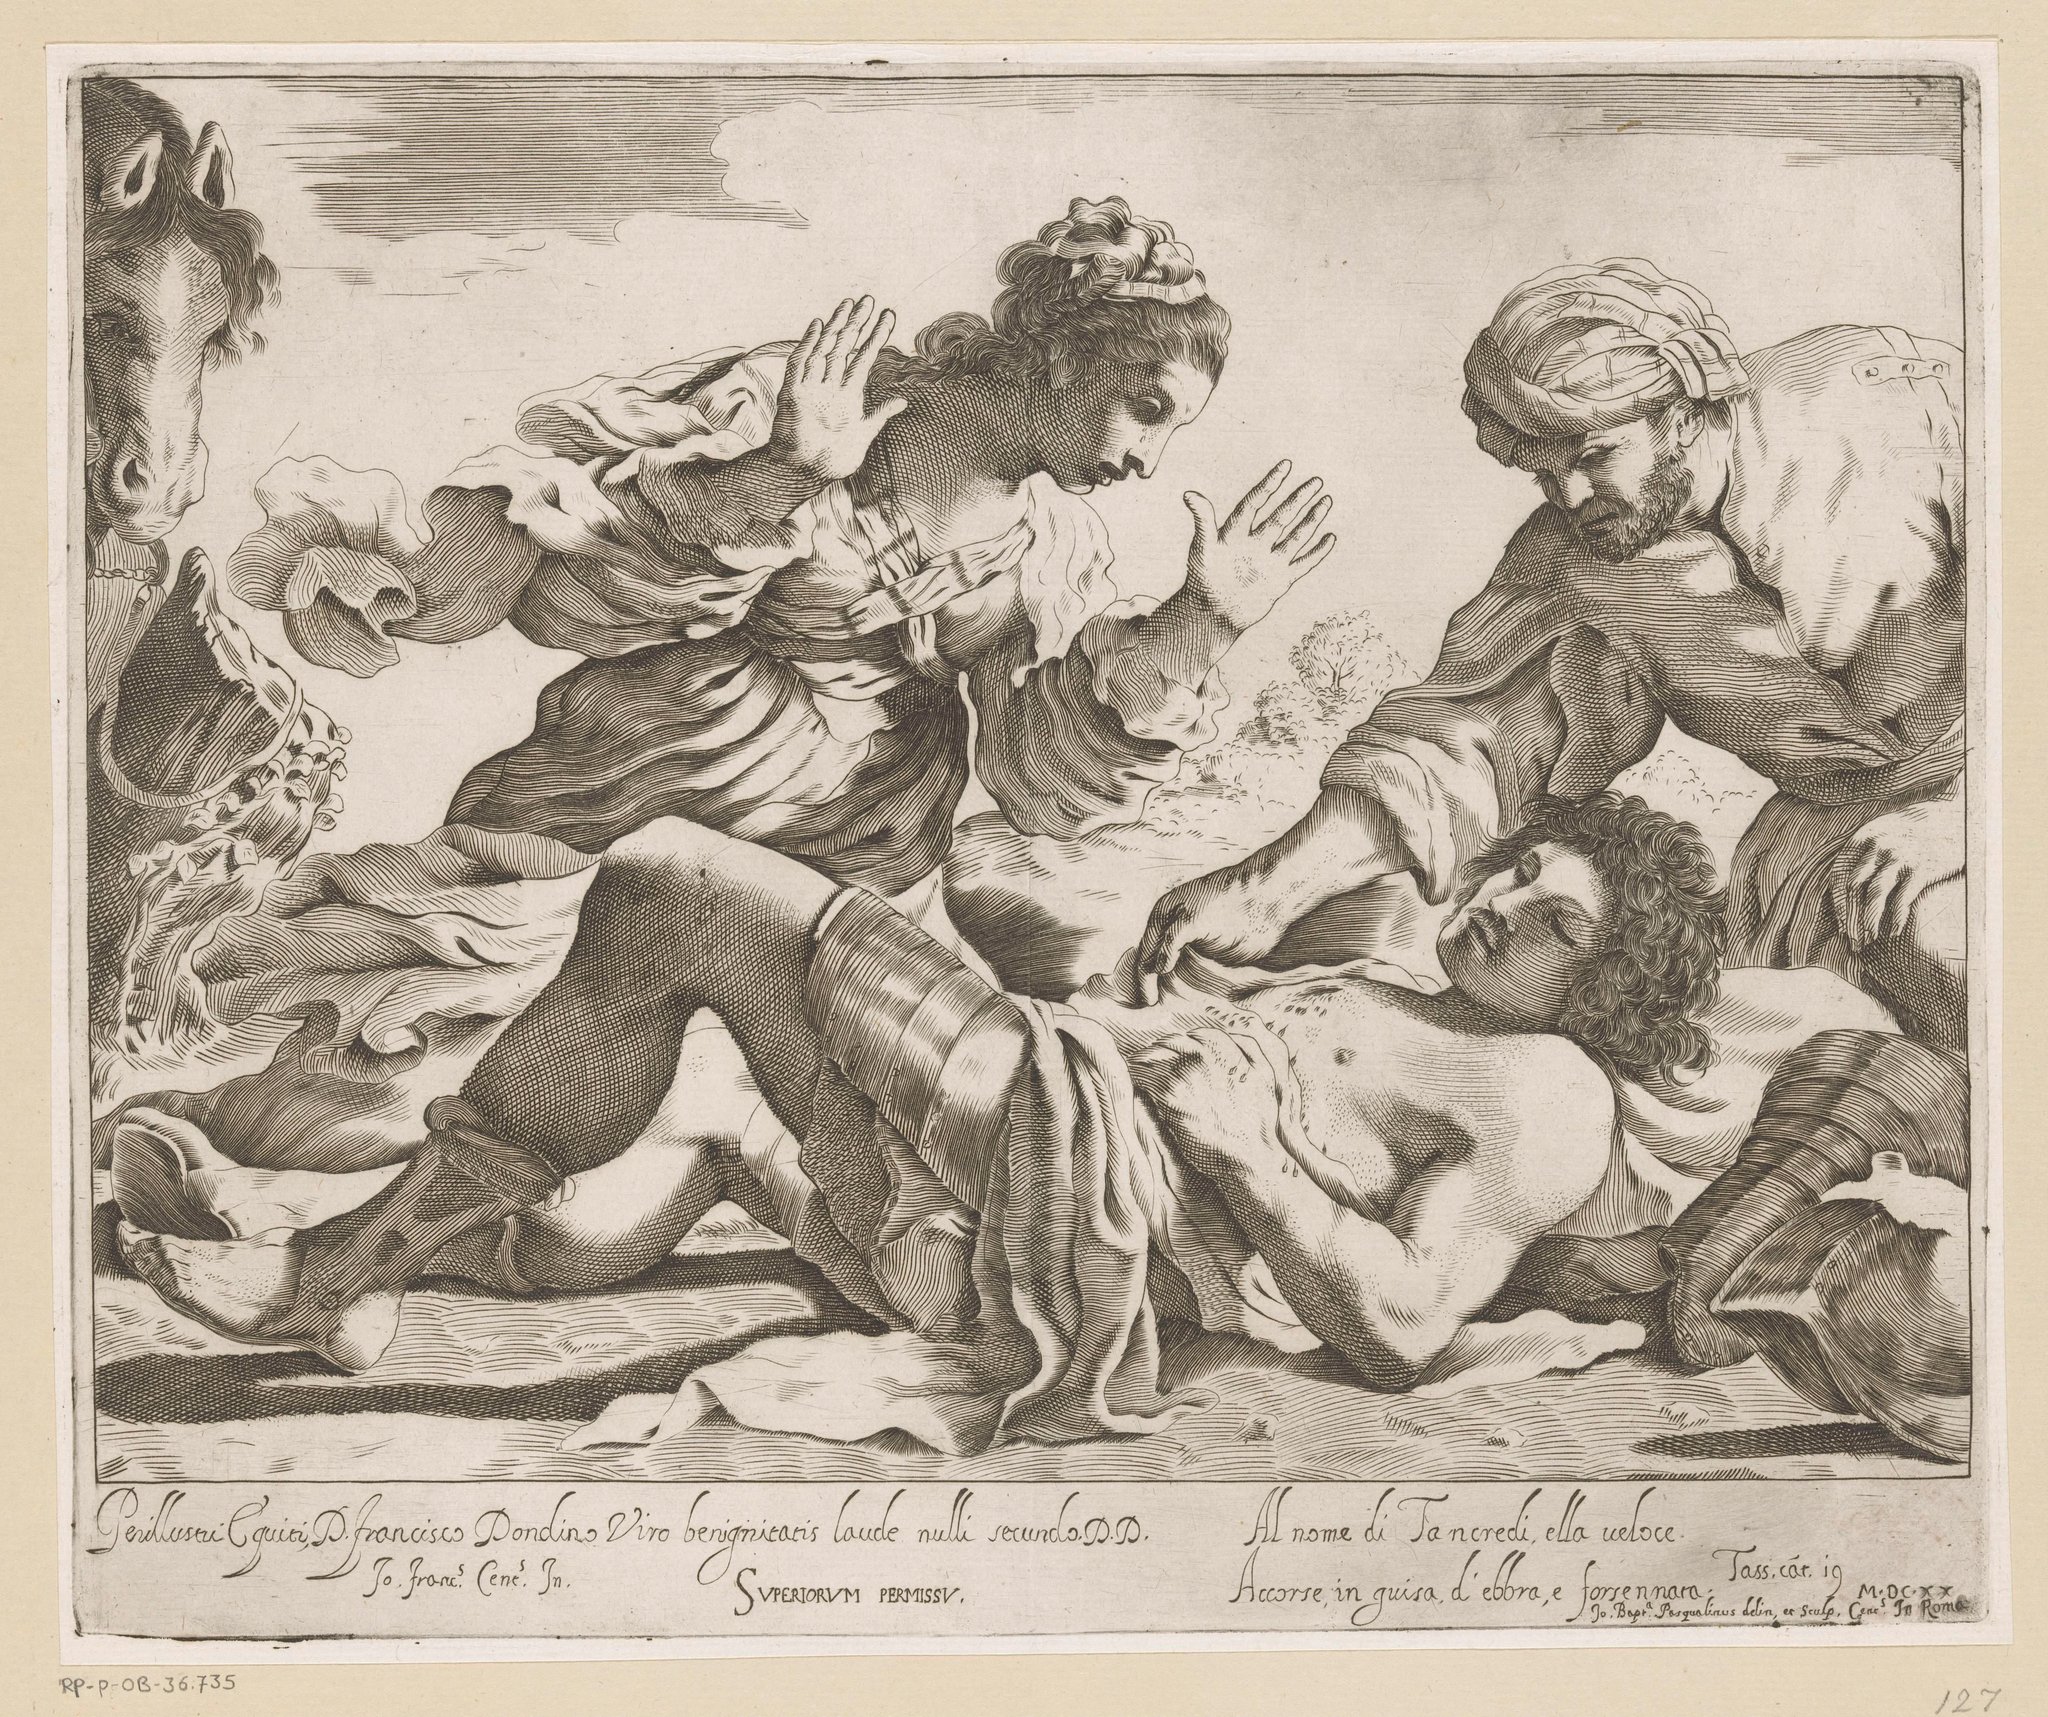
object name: print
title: Erminia en Vafrino vinden Tancredi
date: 1620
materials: paper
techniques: engraving, intaglio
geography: italy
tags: erminia, tancred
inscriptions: collector's mark: Lugt 240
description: Erminia en Vafrino vinden de gewonde Tancredi, liggend op de grond met een wond in zijn borst. In de ondermarge twee verzen in het Italiaans uit Torquato Tasso's 'La Gerusalemme Liberata' (19:104:5-6).